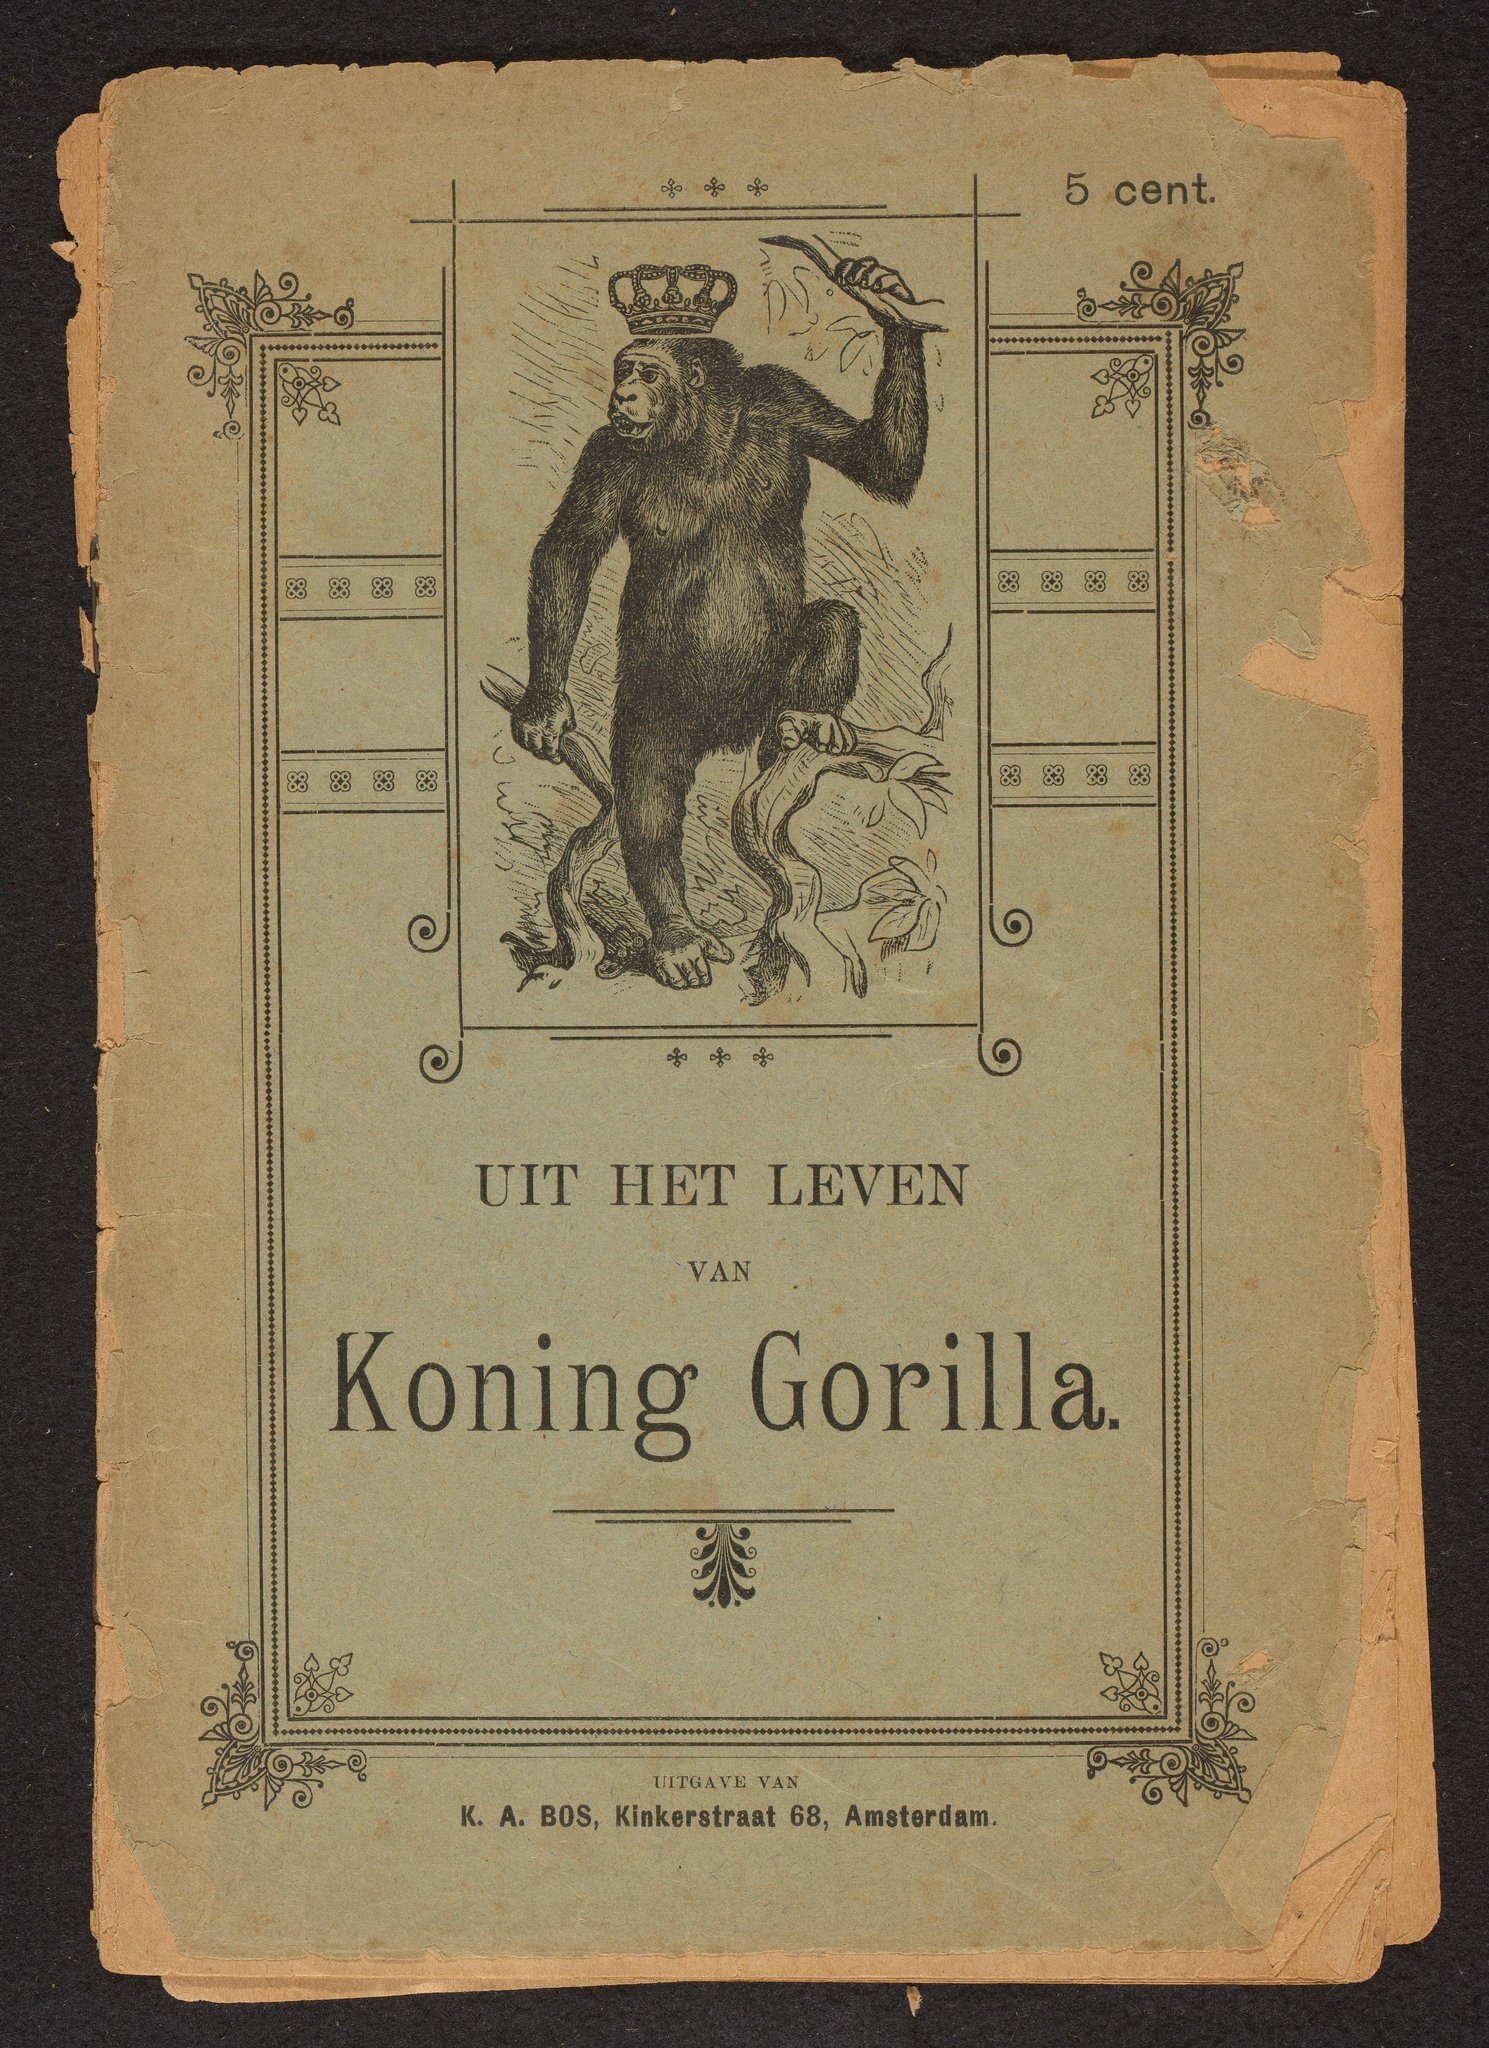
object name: brochure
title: Uit het leven van koning Gorilla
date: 1897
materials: paper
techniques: printing, sewing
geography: amsterdam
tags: brussels, willem iii (koning der nederlanden), netherlands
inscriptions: date